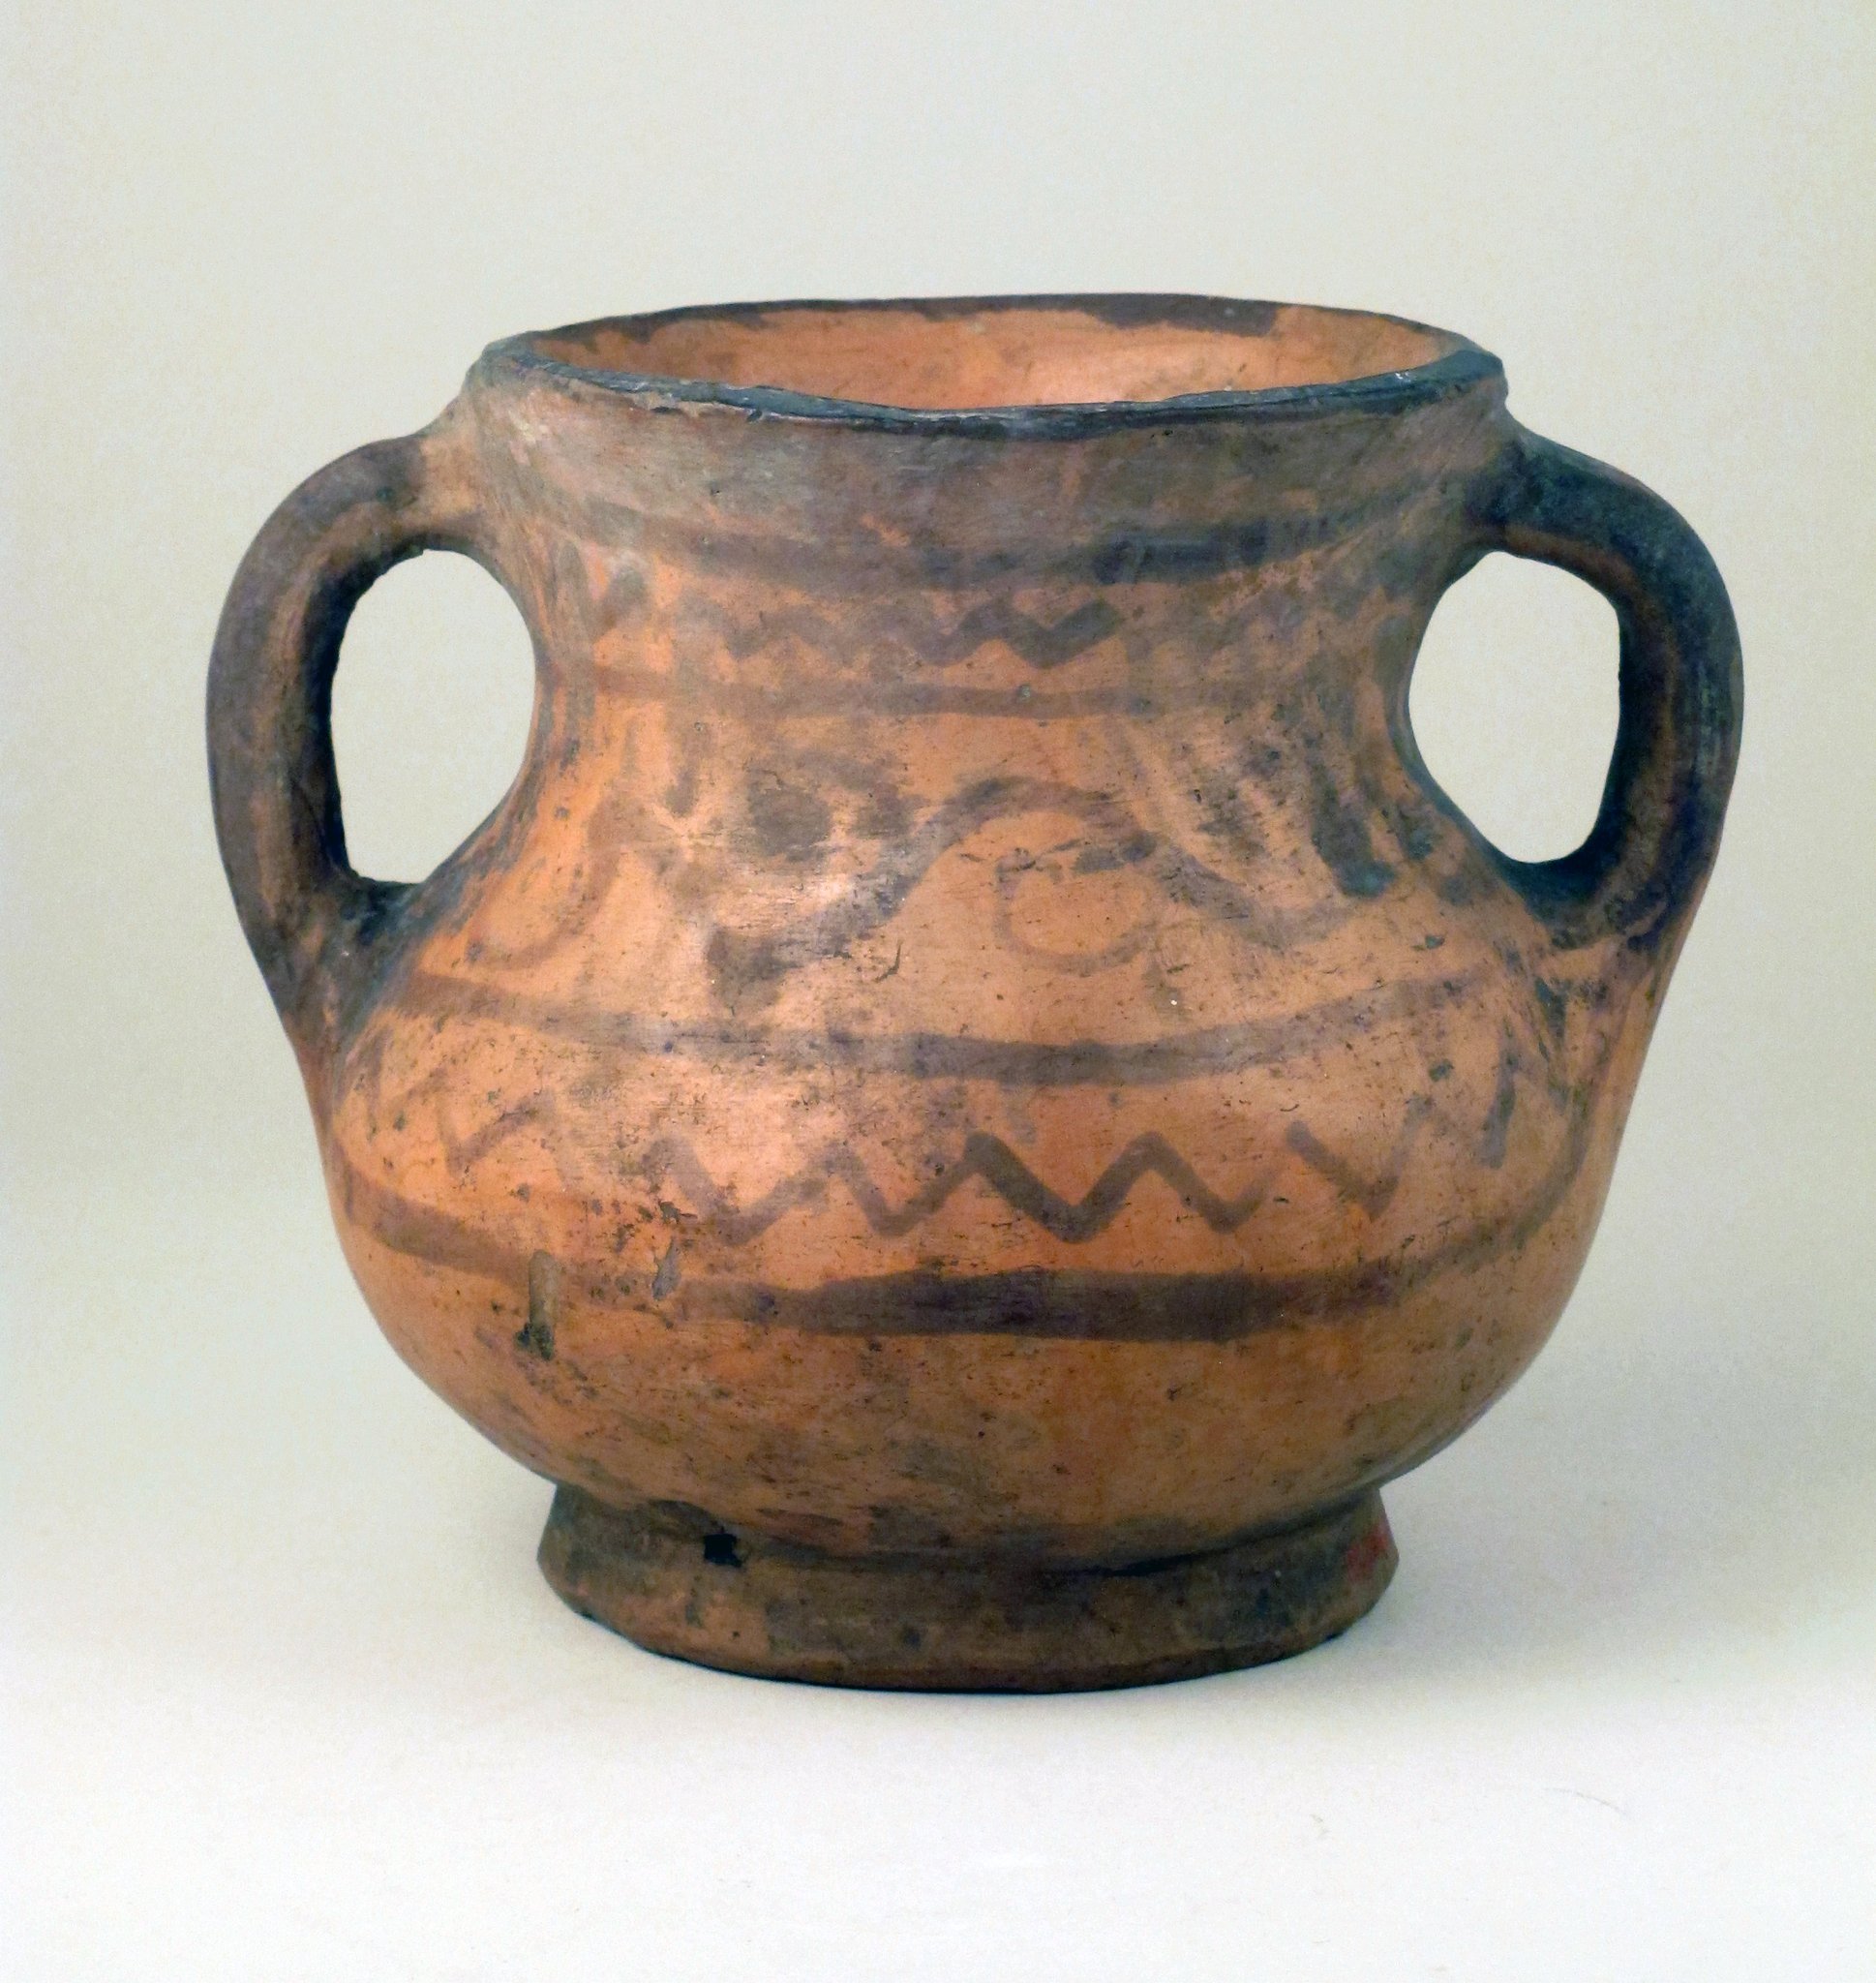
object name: vase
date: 7000 BCE-330 CE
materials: terracotta